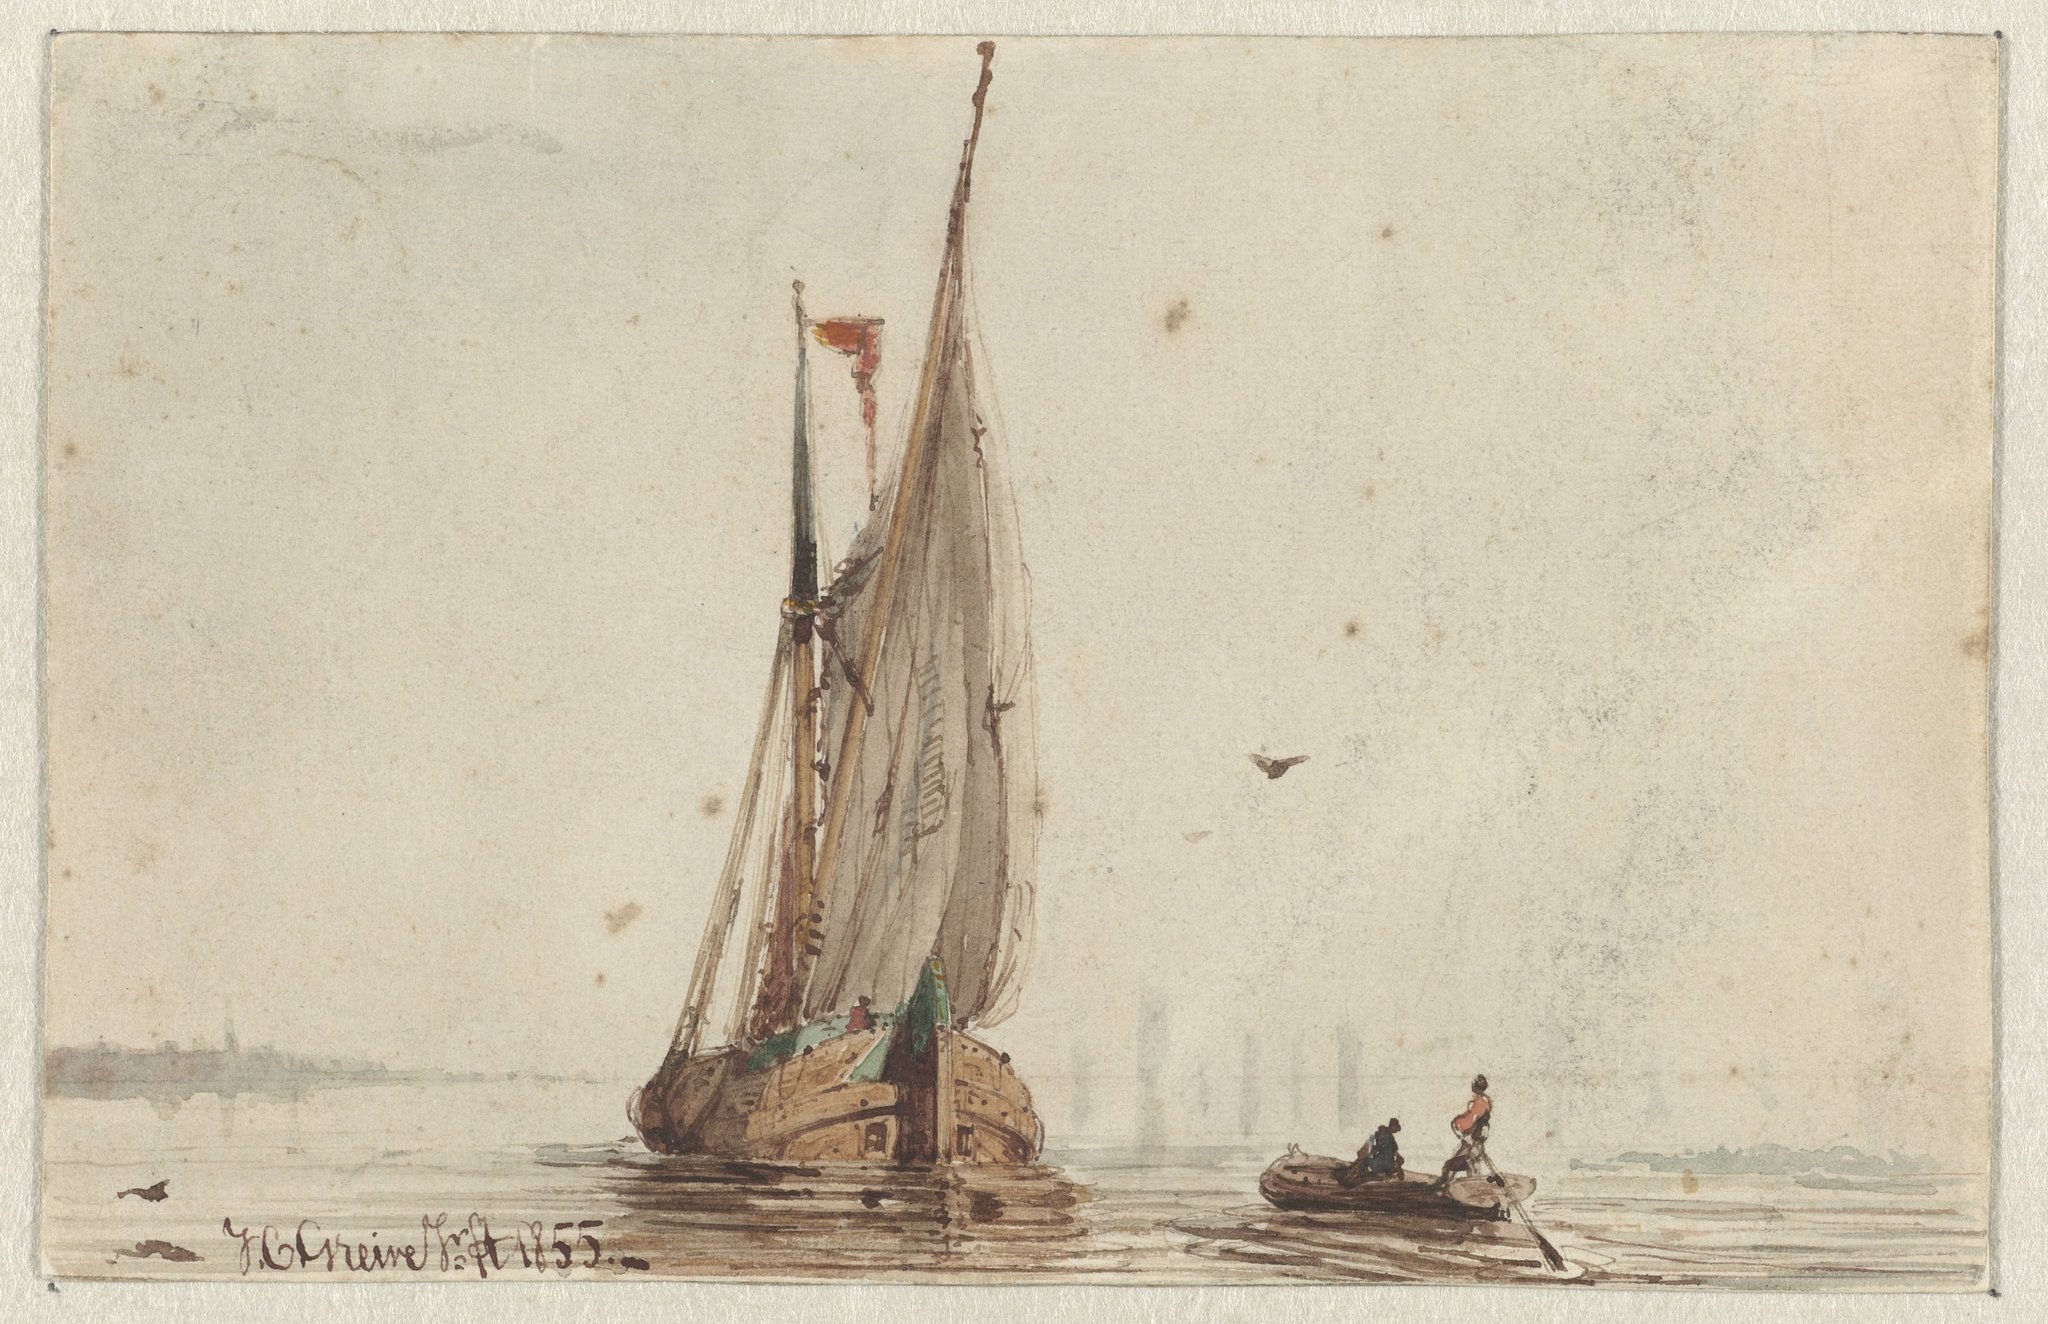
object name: drawing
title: Sloep bij een zeilschip op het water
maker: johan conrad greive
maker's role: draughtsman, painter, print maker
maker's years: 1837-1891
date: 1855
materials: ink, paper, watercolor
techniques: brush, pen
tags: sailing-ship, sailing-boat, river